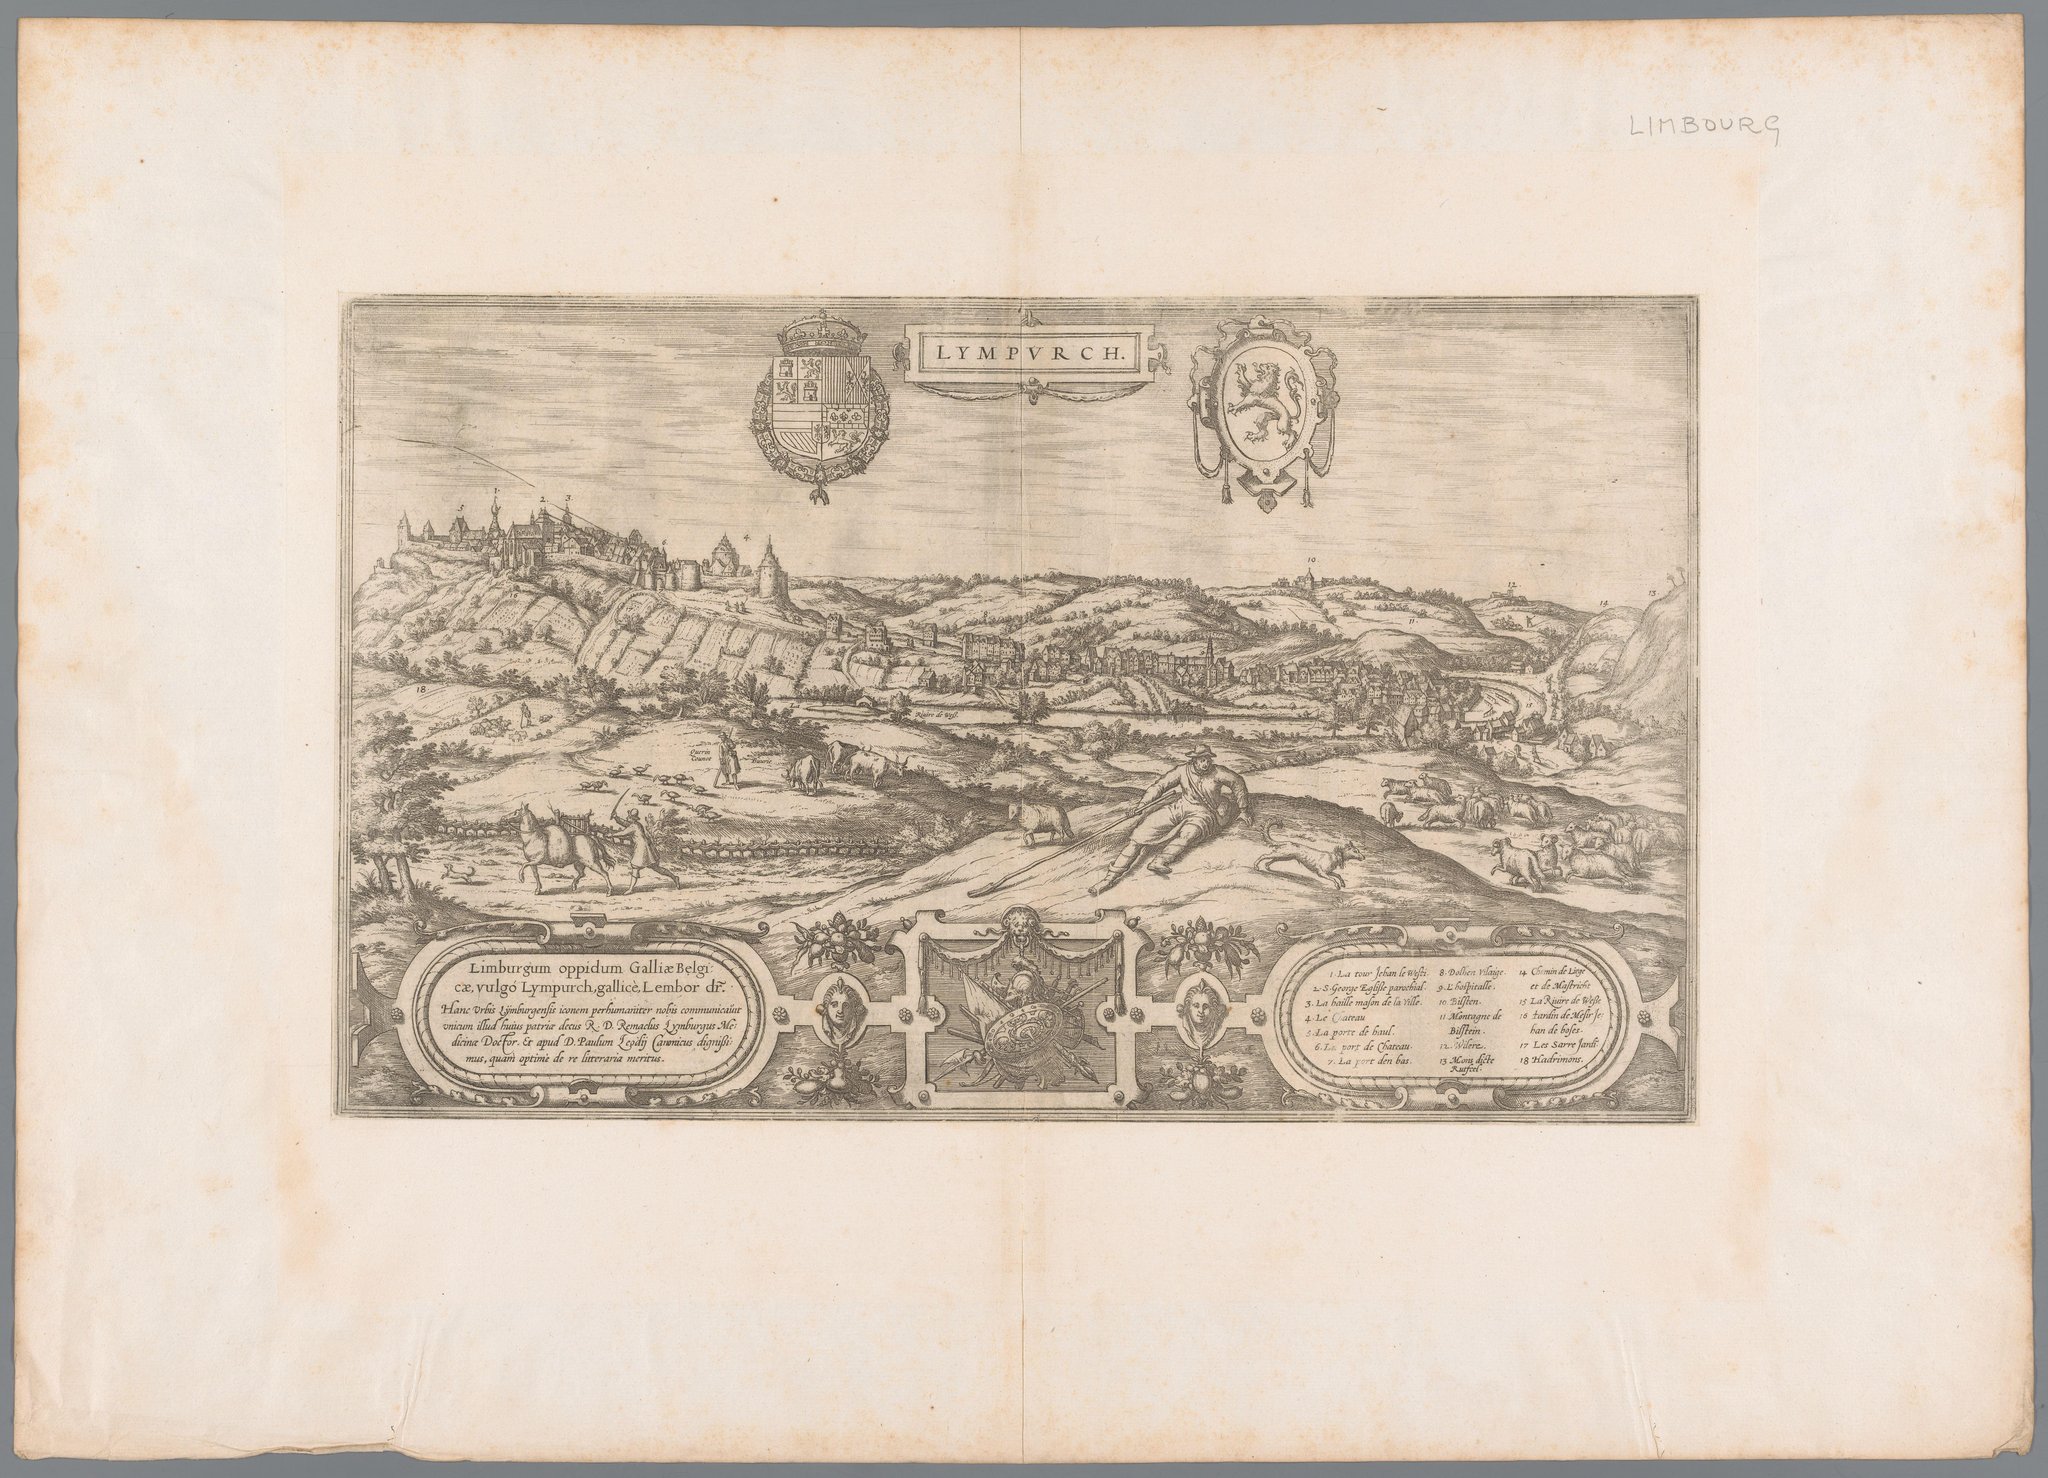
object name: book illustration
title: Gezicht op de Belgische stad Limburg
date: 1623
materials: paper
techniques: etching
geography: cologne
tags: maps of cities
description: Prent uit: Braun, Georg. Civitates orbis terrarum (...), 6 dln. Keulen: Peter von Brachel, 1623, dl. 2, nr. 18.